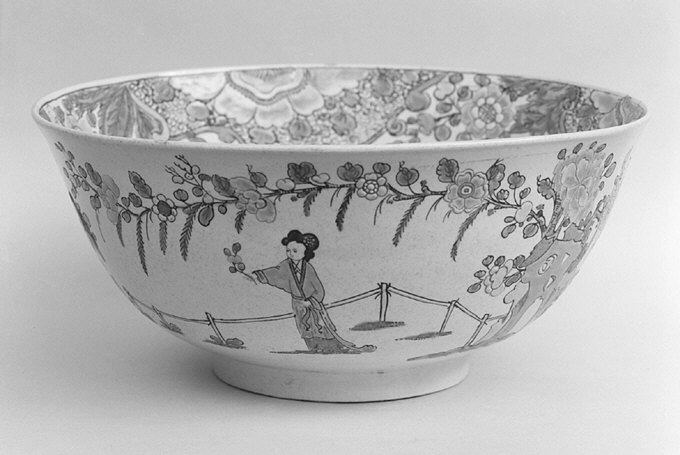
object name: bowl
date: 1750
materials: stoneware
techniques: salt glaze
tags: women,flowers